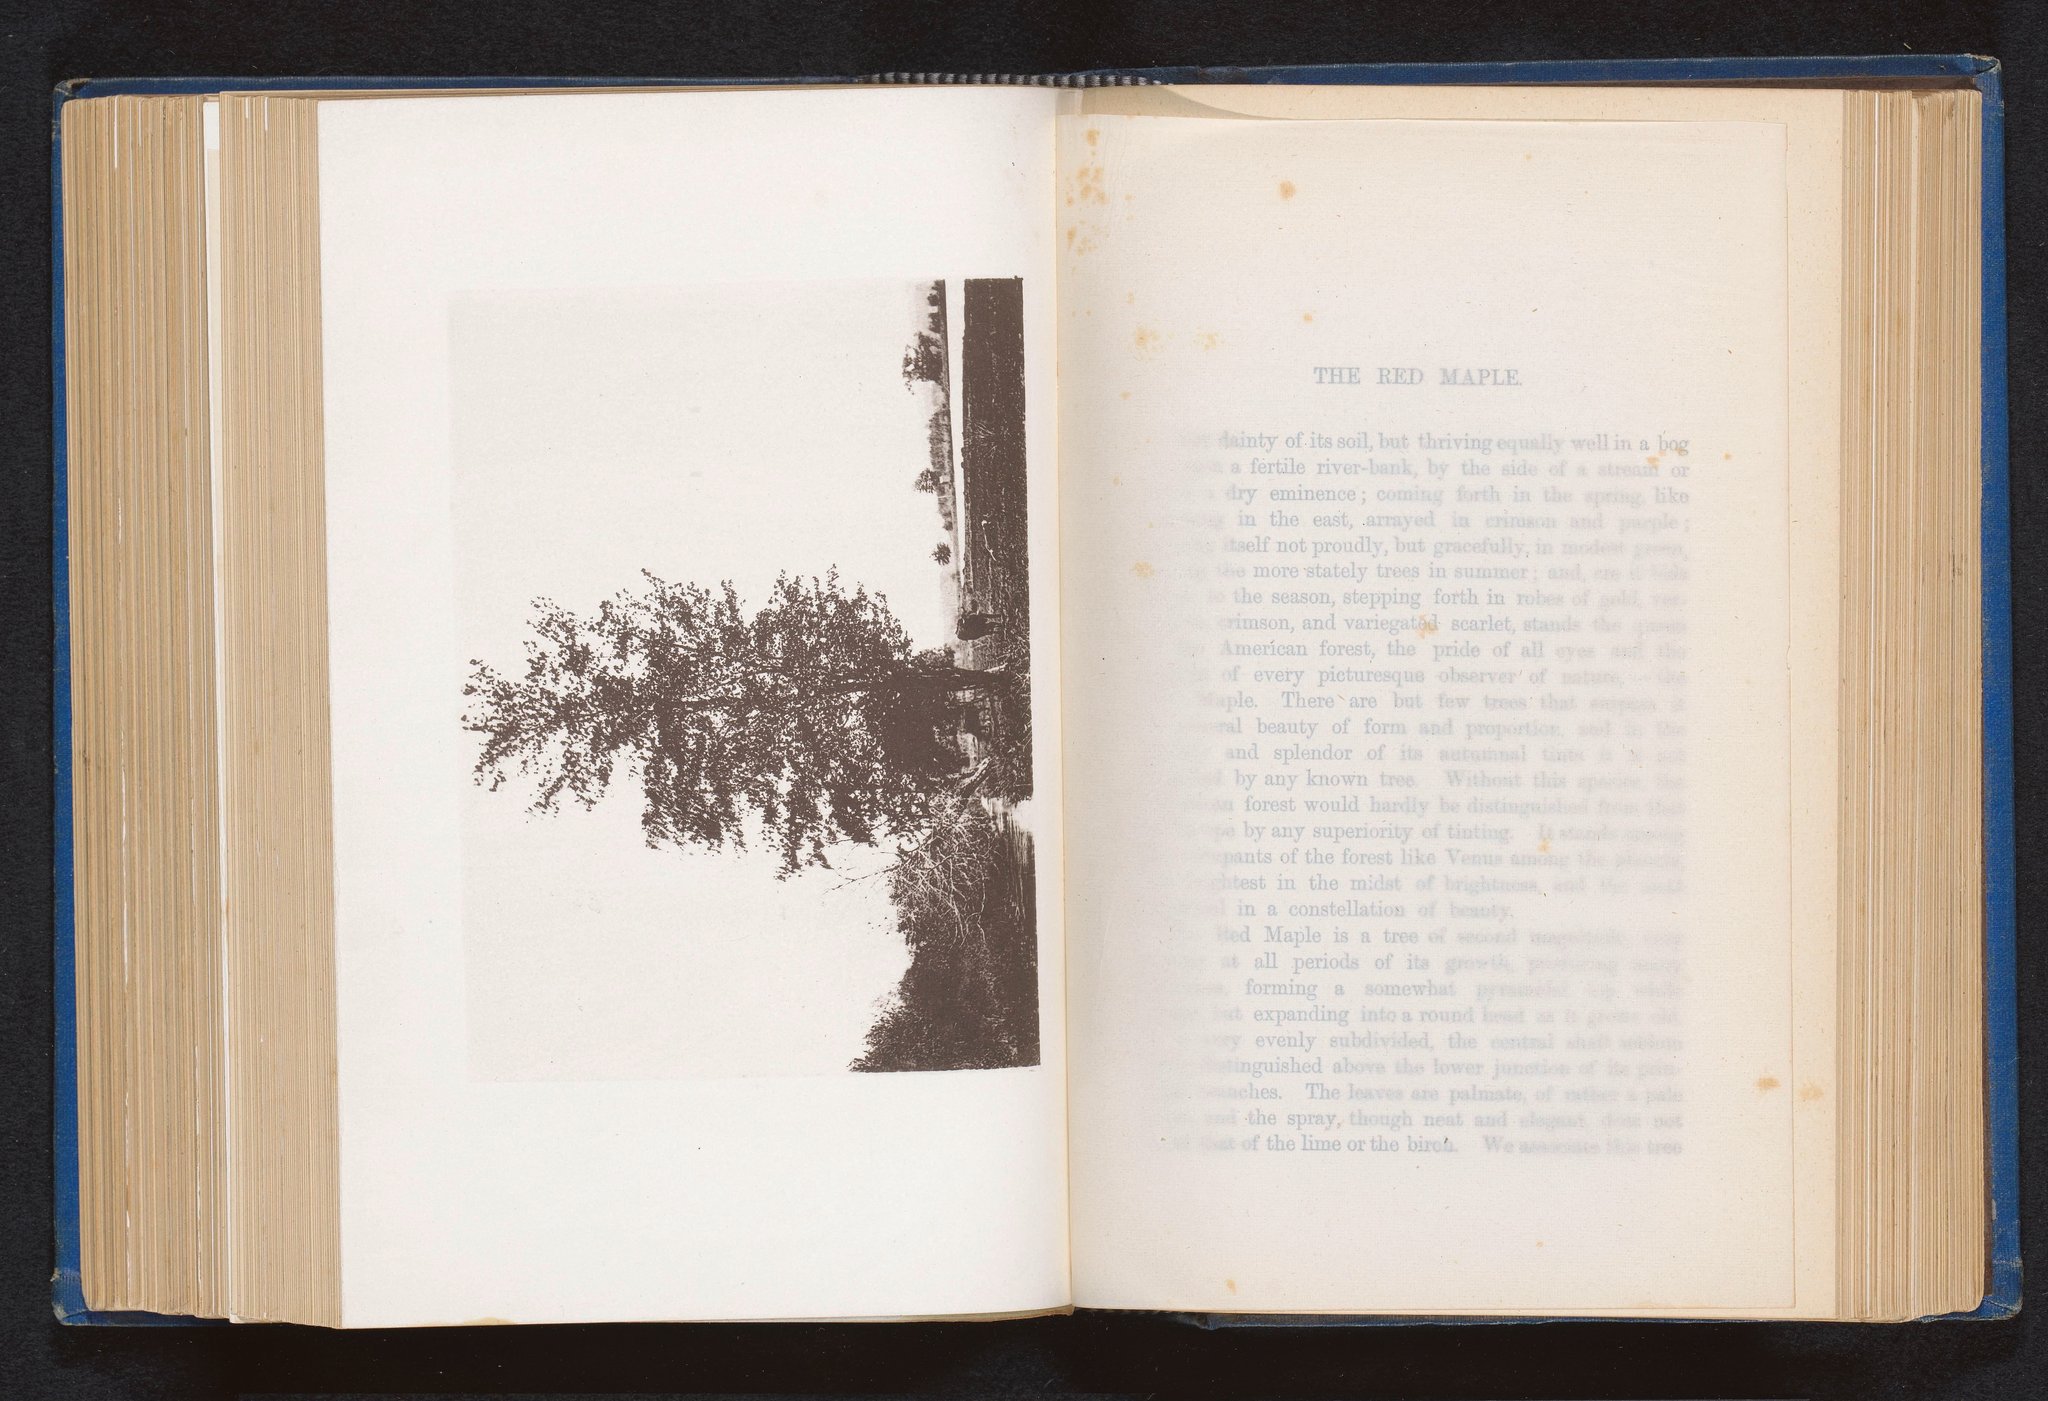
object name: photomechanical print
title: Gezicht op een rode esdoorn te Cambridge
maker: Anonymous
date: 1872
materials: paper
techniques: photograph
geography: cambridge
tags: landscapes, river, trees: acer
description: Prent op tweede ongenummerde pagina na pagina 298.